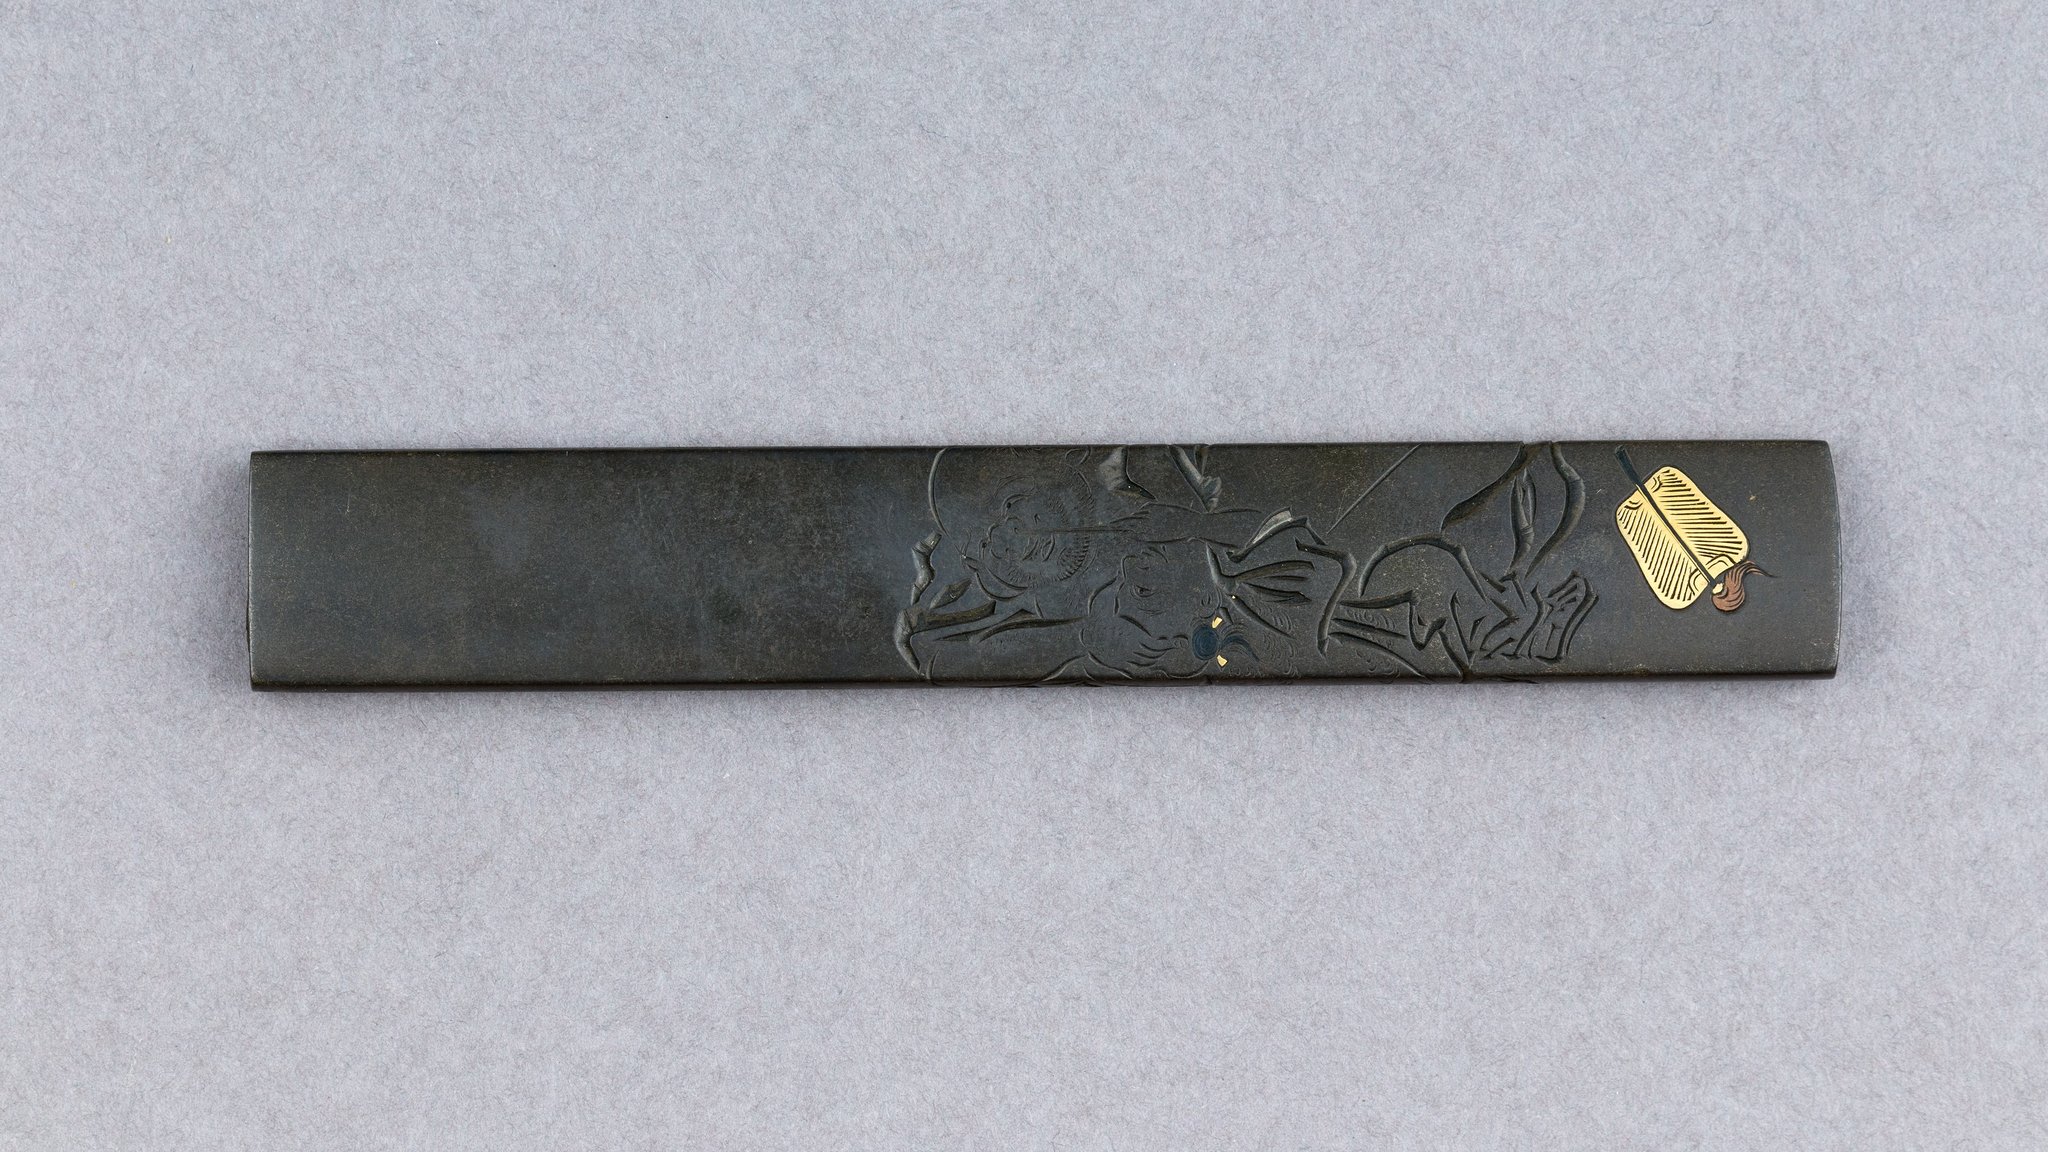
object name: knife handle kozuka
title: Knife Handle (Kozuka)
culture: japanese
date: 1615-1868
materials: silver alloy, gold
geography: japan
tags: men